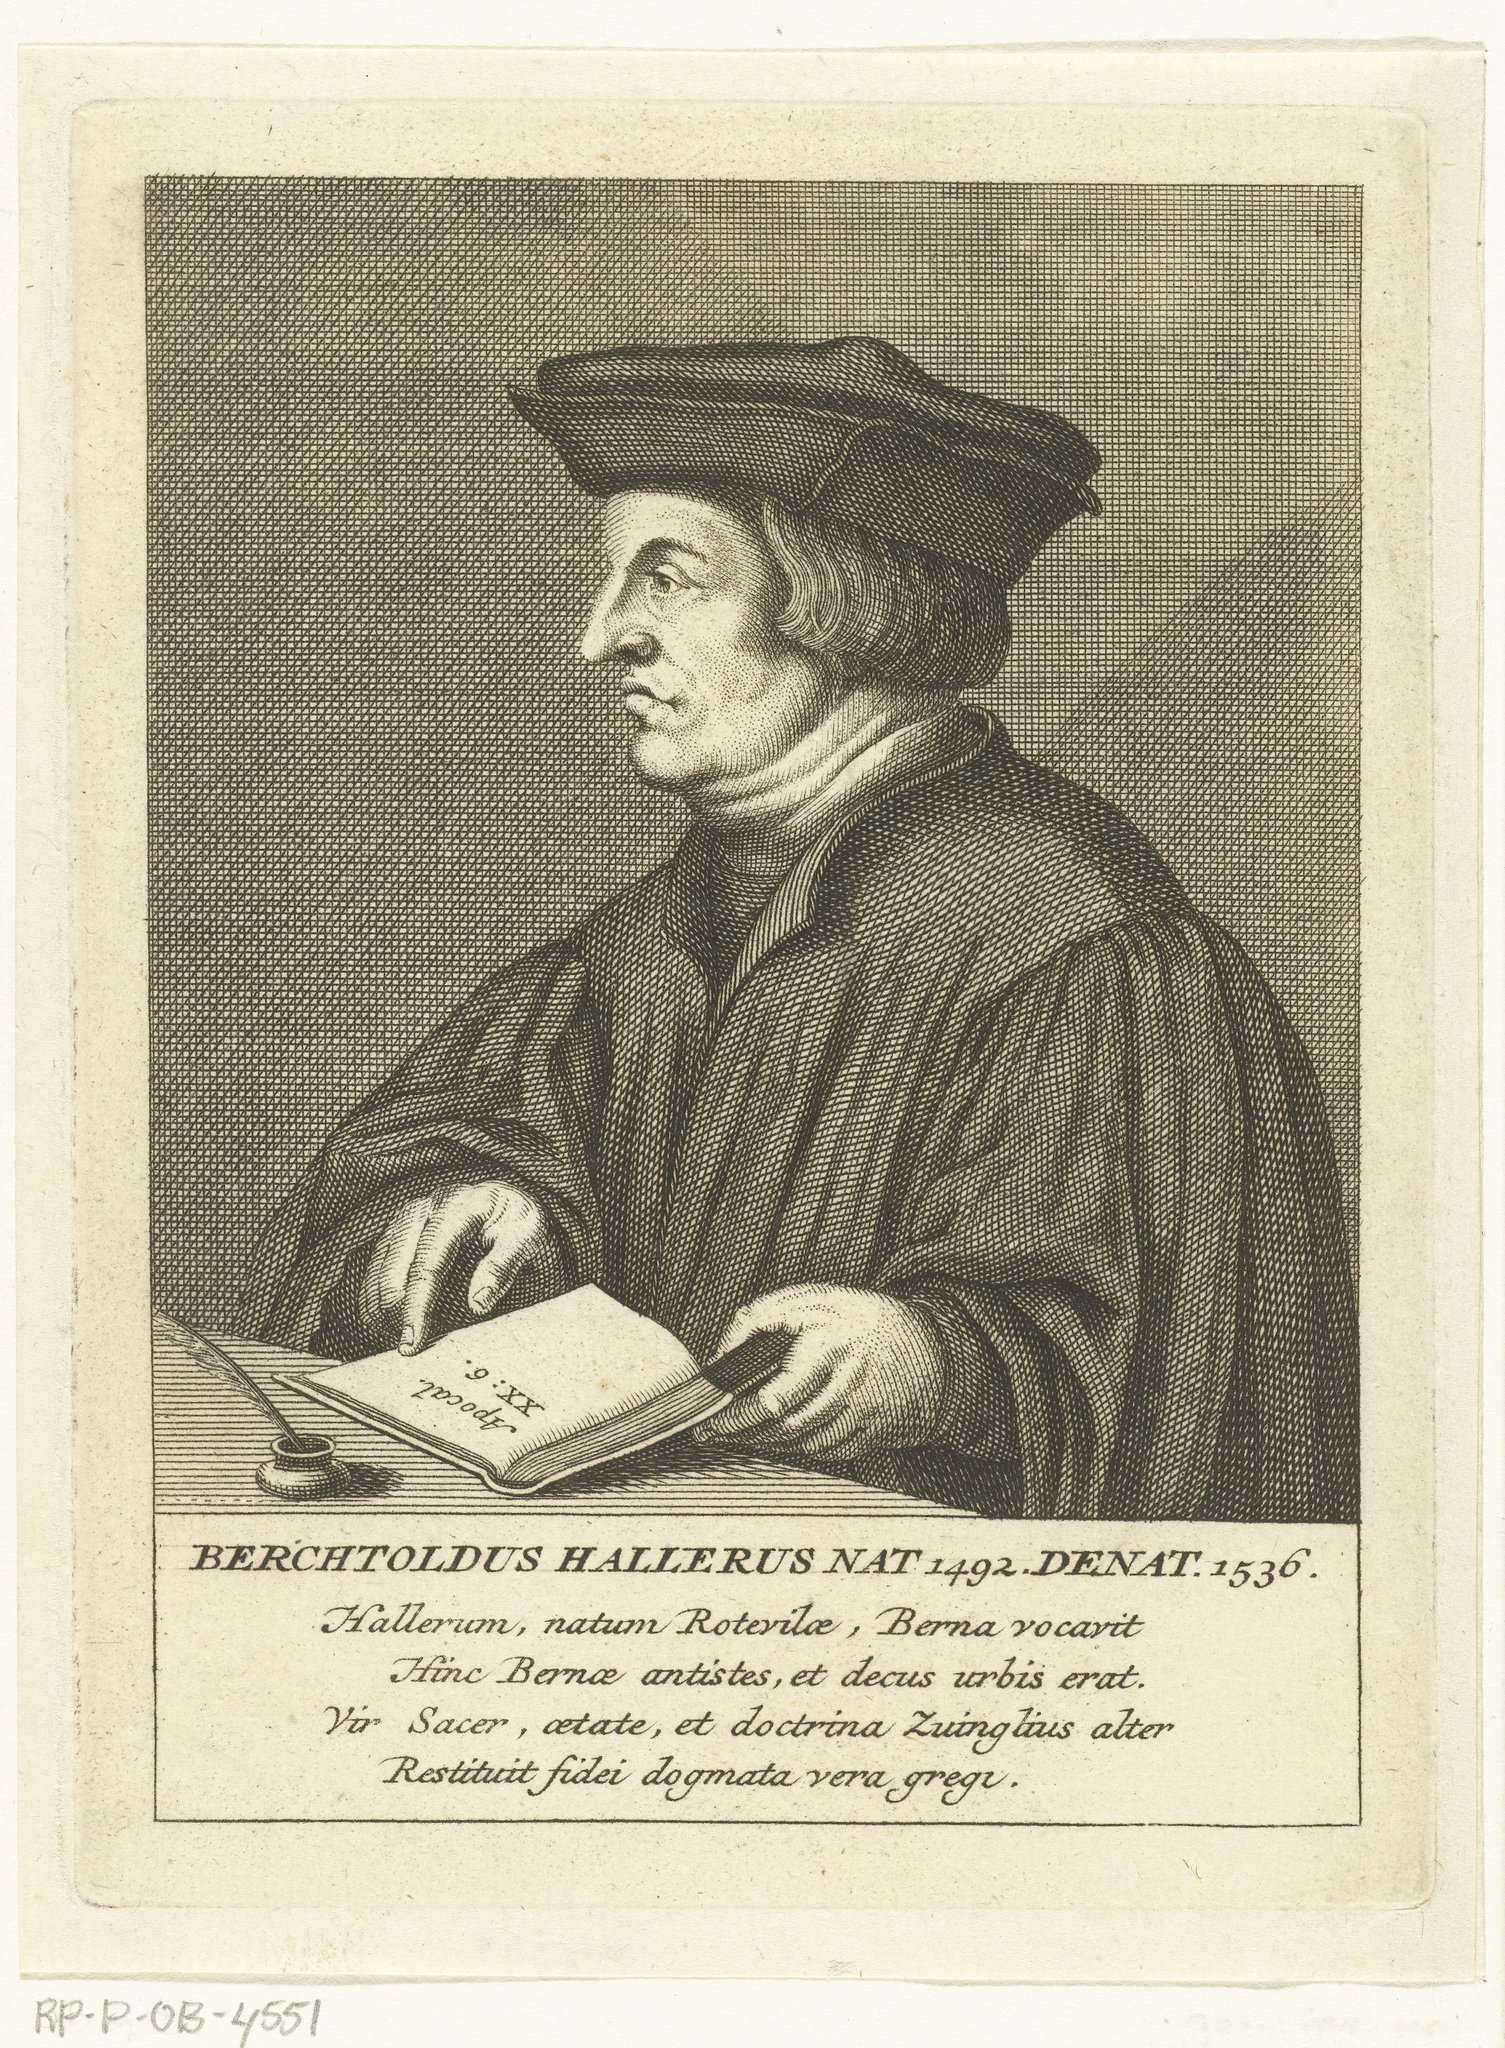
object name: print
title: Berchtoldus Hallerus nat (...) dogmata vera gregi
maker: françois van bleyswijck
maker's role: draughtsman, print maker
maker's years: 1671-1746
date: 1681-1746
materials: paper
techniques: engraving, etching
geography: leiden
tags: bern, theoloog, berchtold haller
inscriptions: collector's mark: Lugt 2228